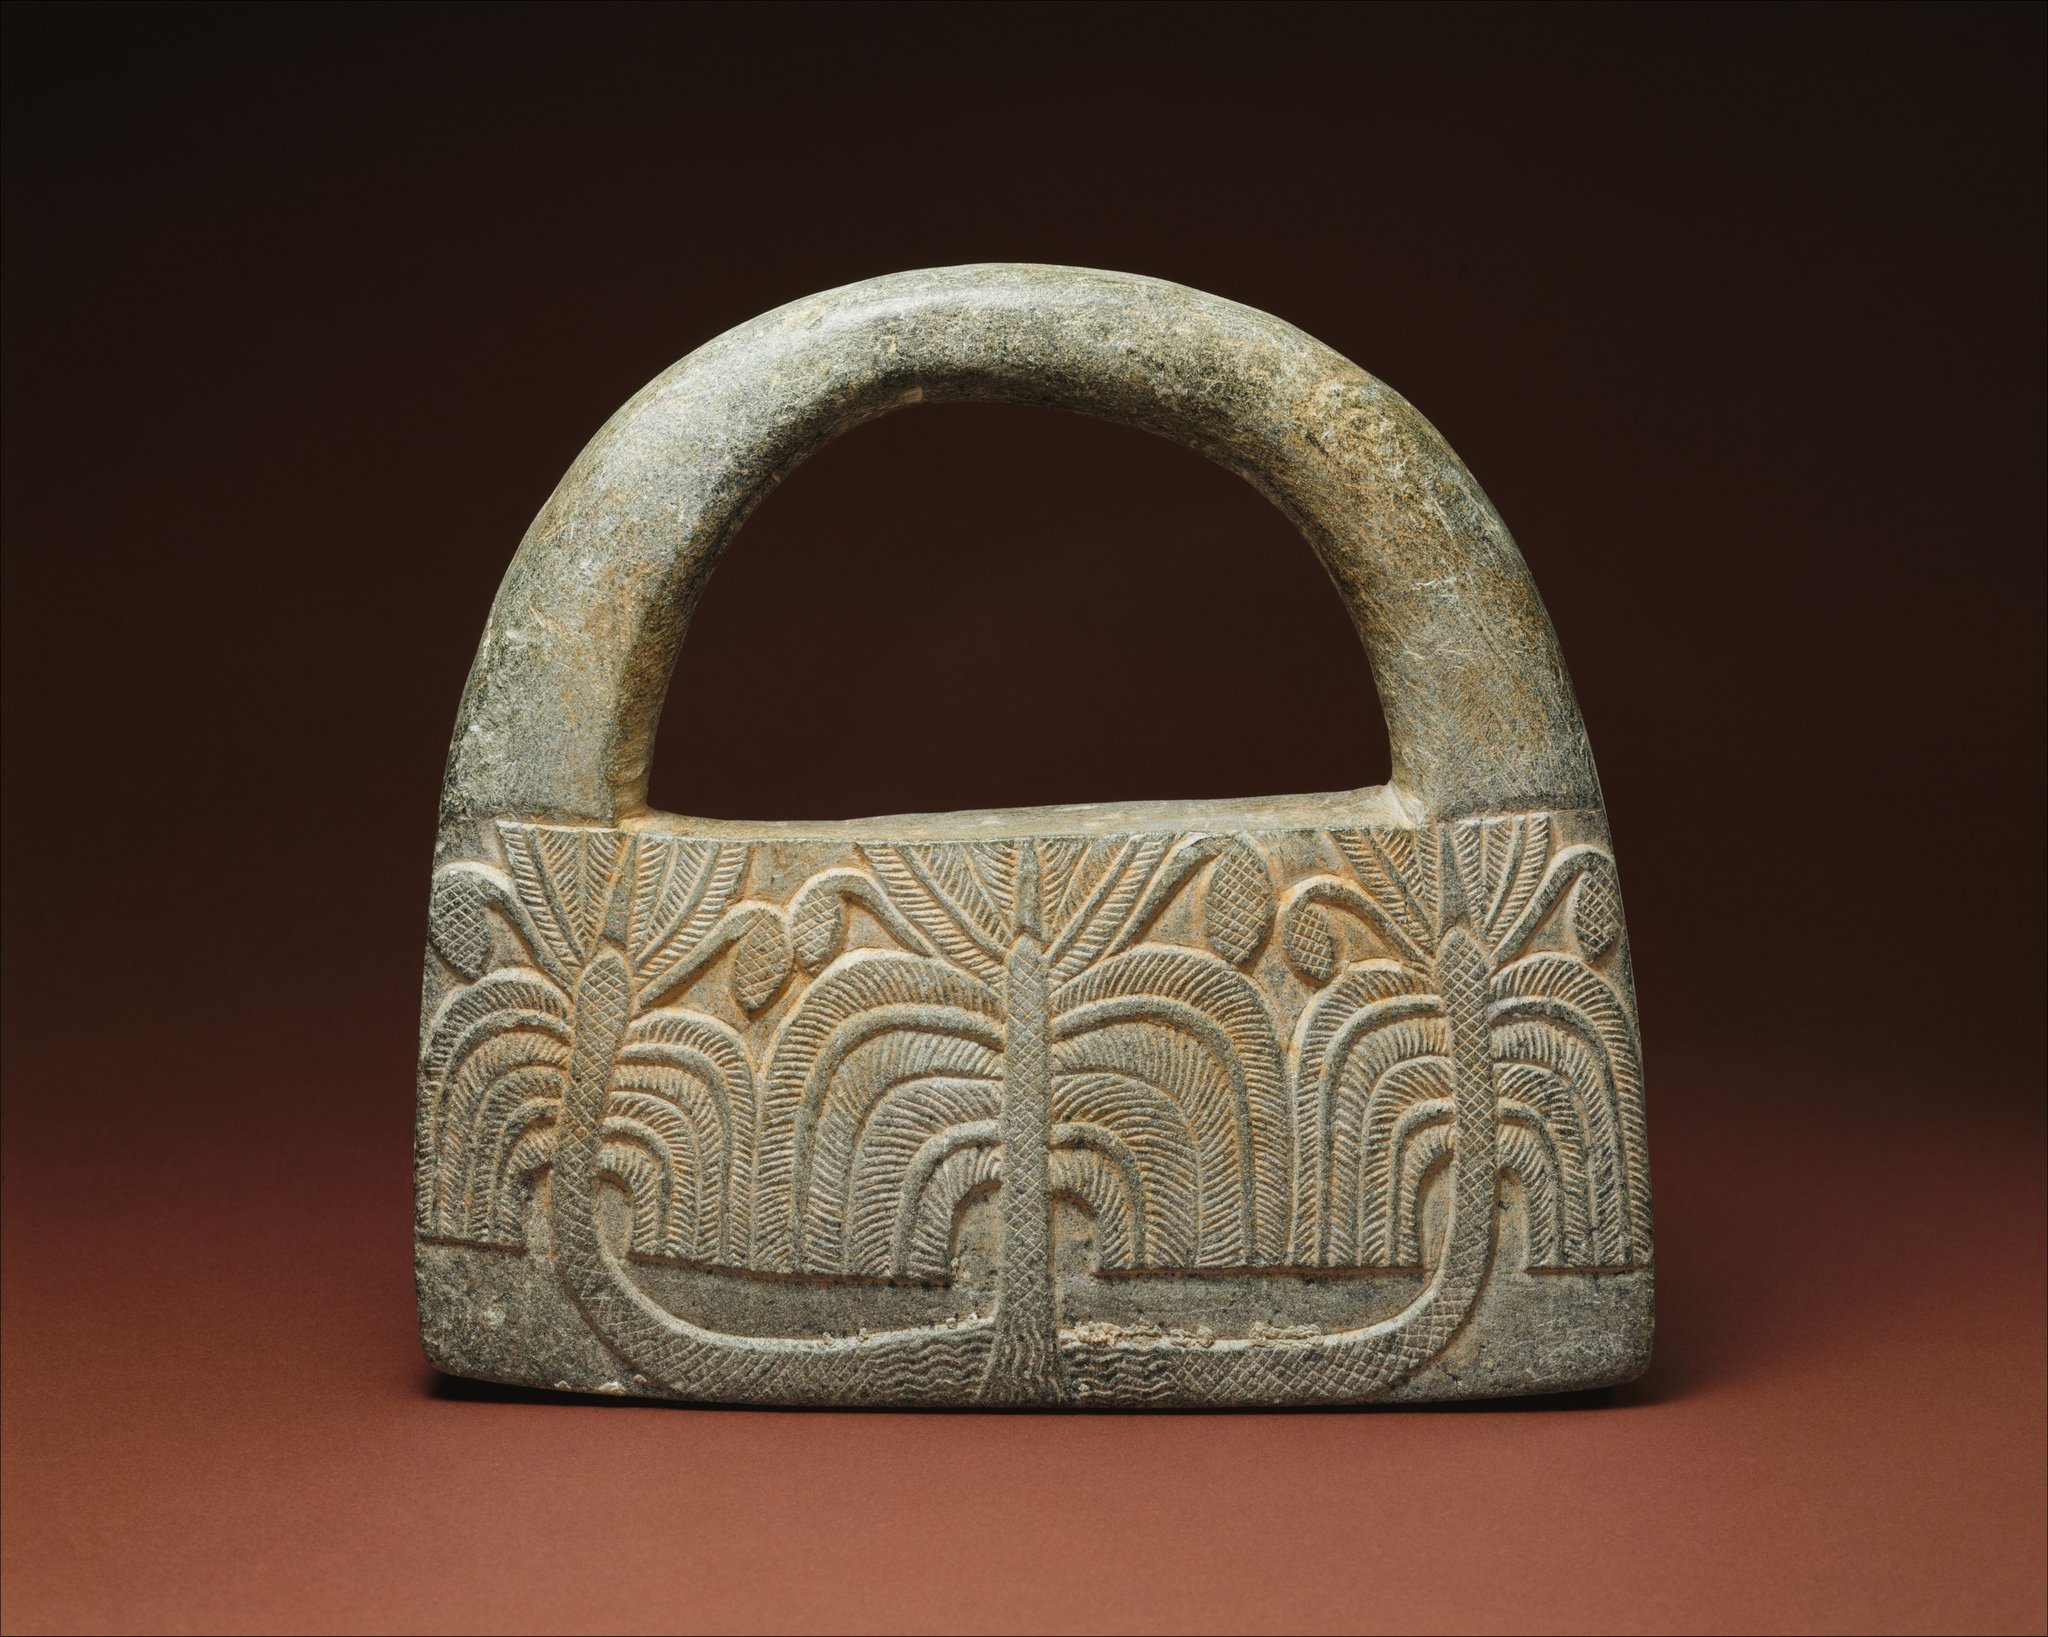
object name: object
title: Object with a handle, perhaps a weight; palm trees and guilloche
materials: mineral, stone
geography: persian gulf region or southern iran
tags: palms